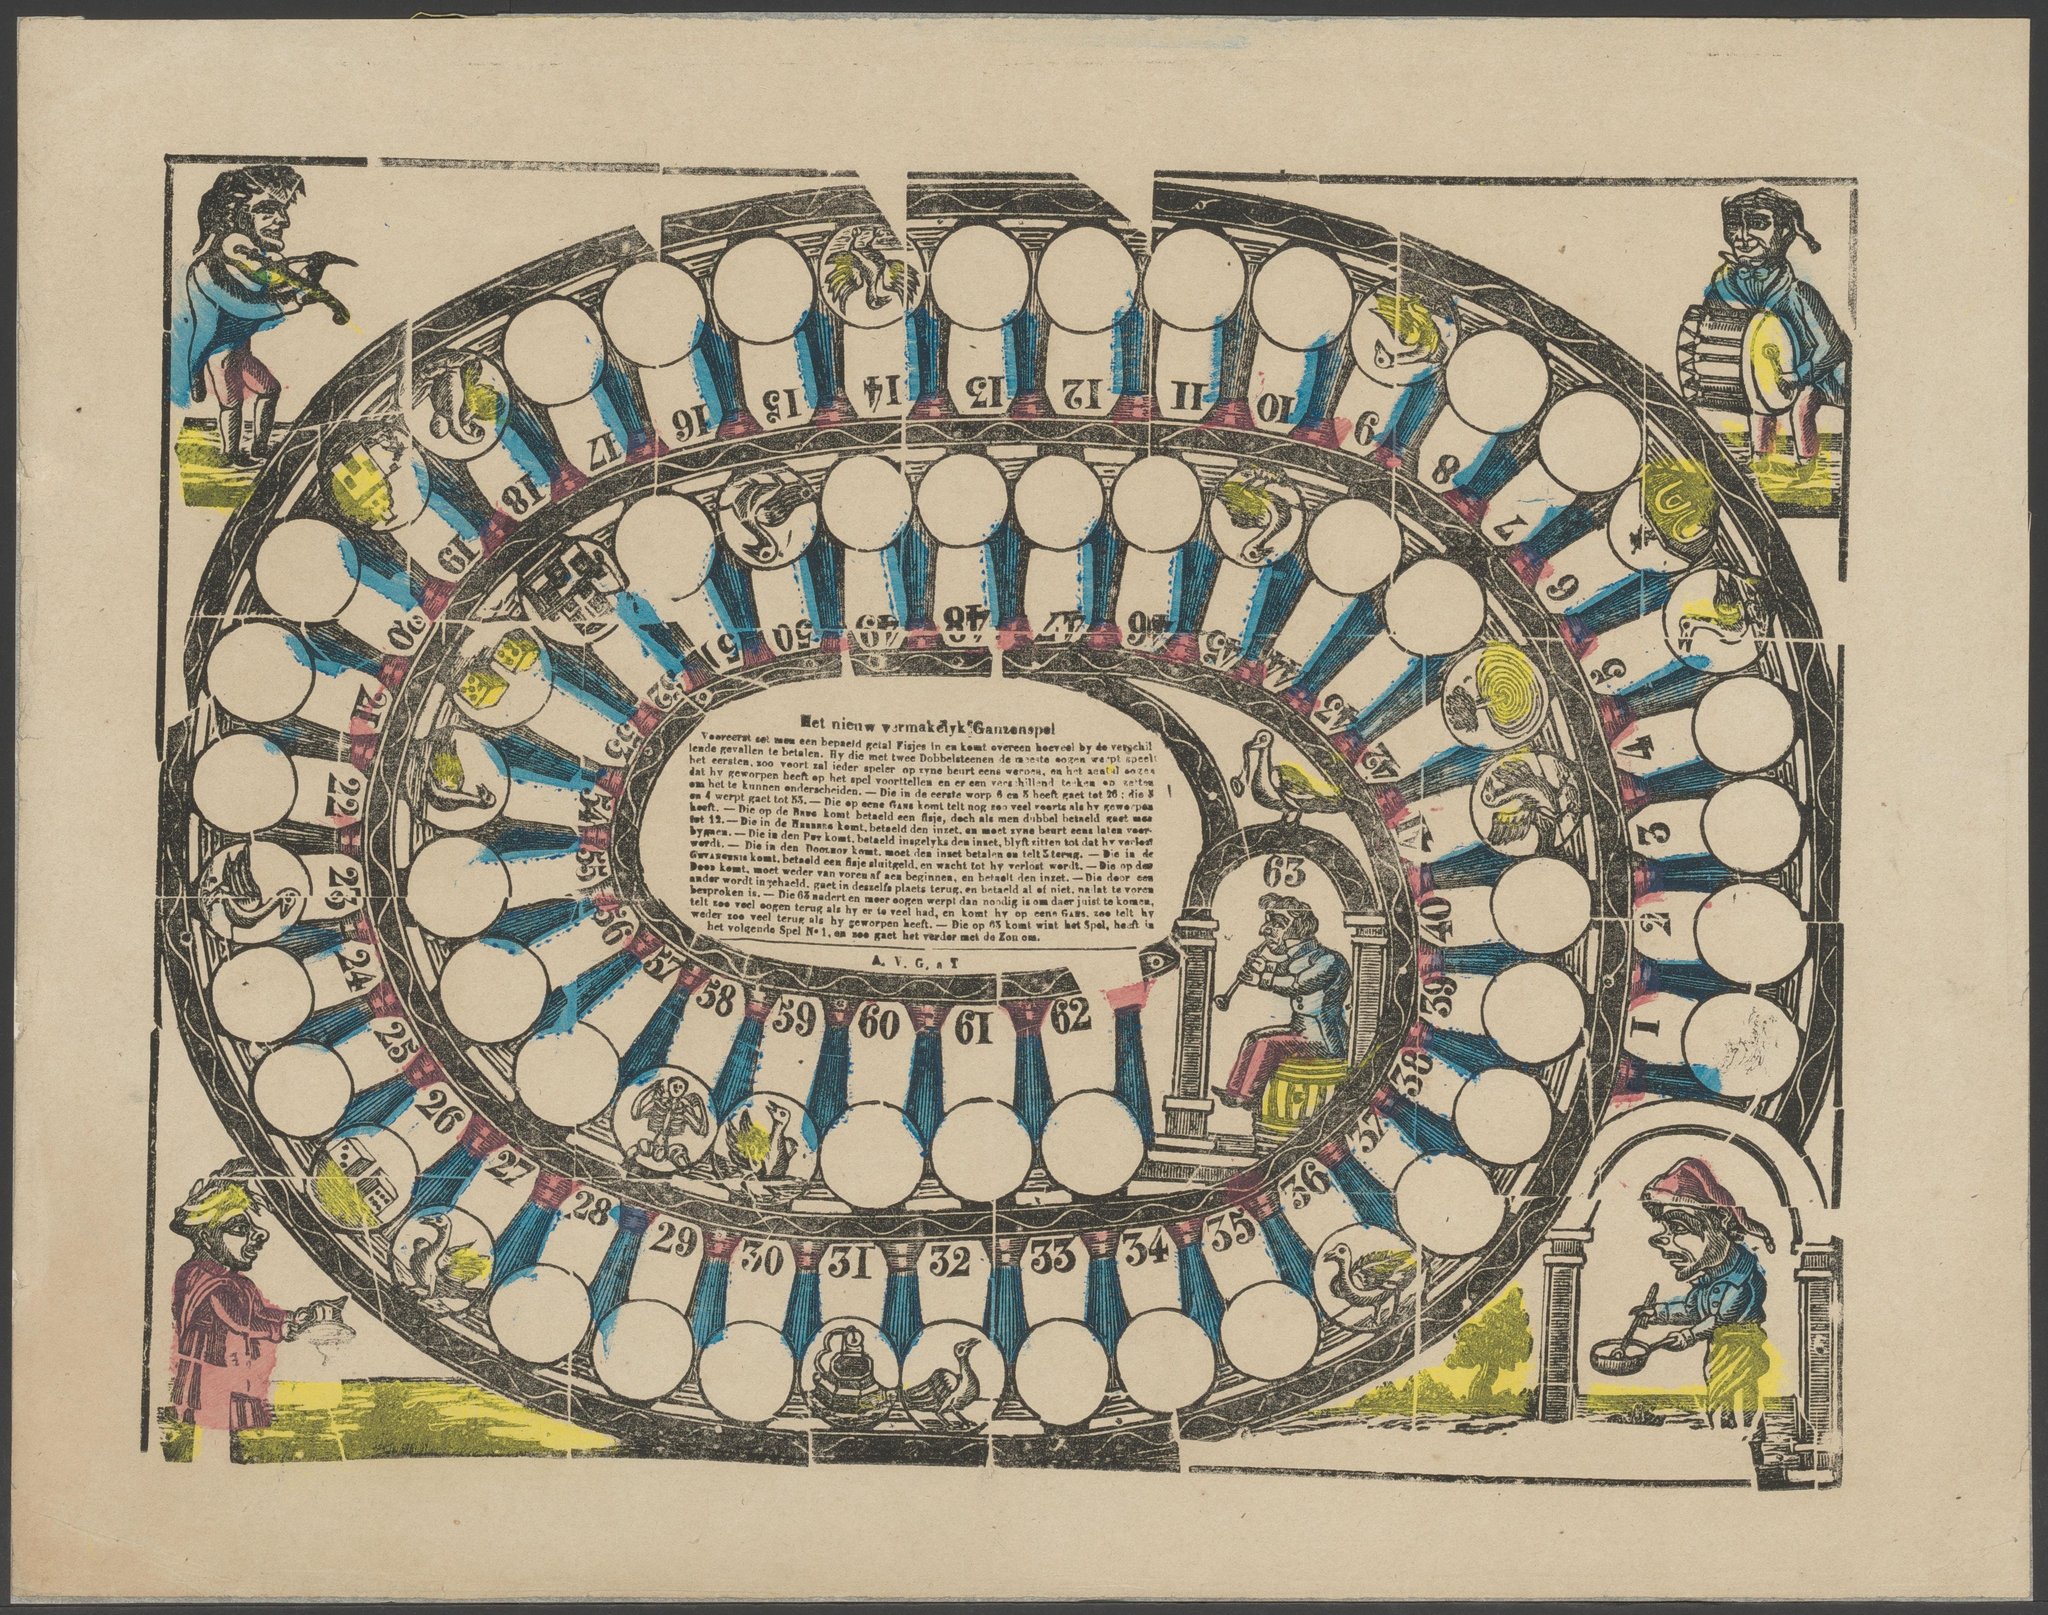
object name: print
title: Speelbord van een ganzenspel met figuren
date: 1856-1870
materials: paper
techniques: hand coloring, letterpress printing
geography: turnhout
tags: goose-game, board-games of chance, board-games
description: Ganzenbordspel met een spiraal met vakken genummerd van 1 tot en met 63. In enkele vakken voorstellingen van ganzen. In elke hoek een figuur. Op het middenveld de titel en de spelregels. Onderwerpsrubrieken binnen de Atlas Zeden en Gewoonten: Zeden en gewoonten in engeren zin, Spel en vermaak, Gezelschapsspel II, Ganzenbord en dergelijke.